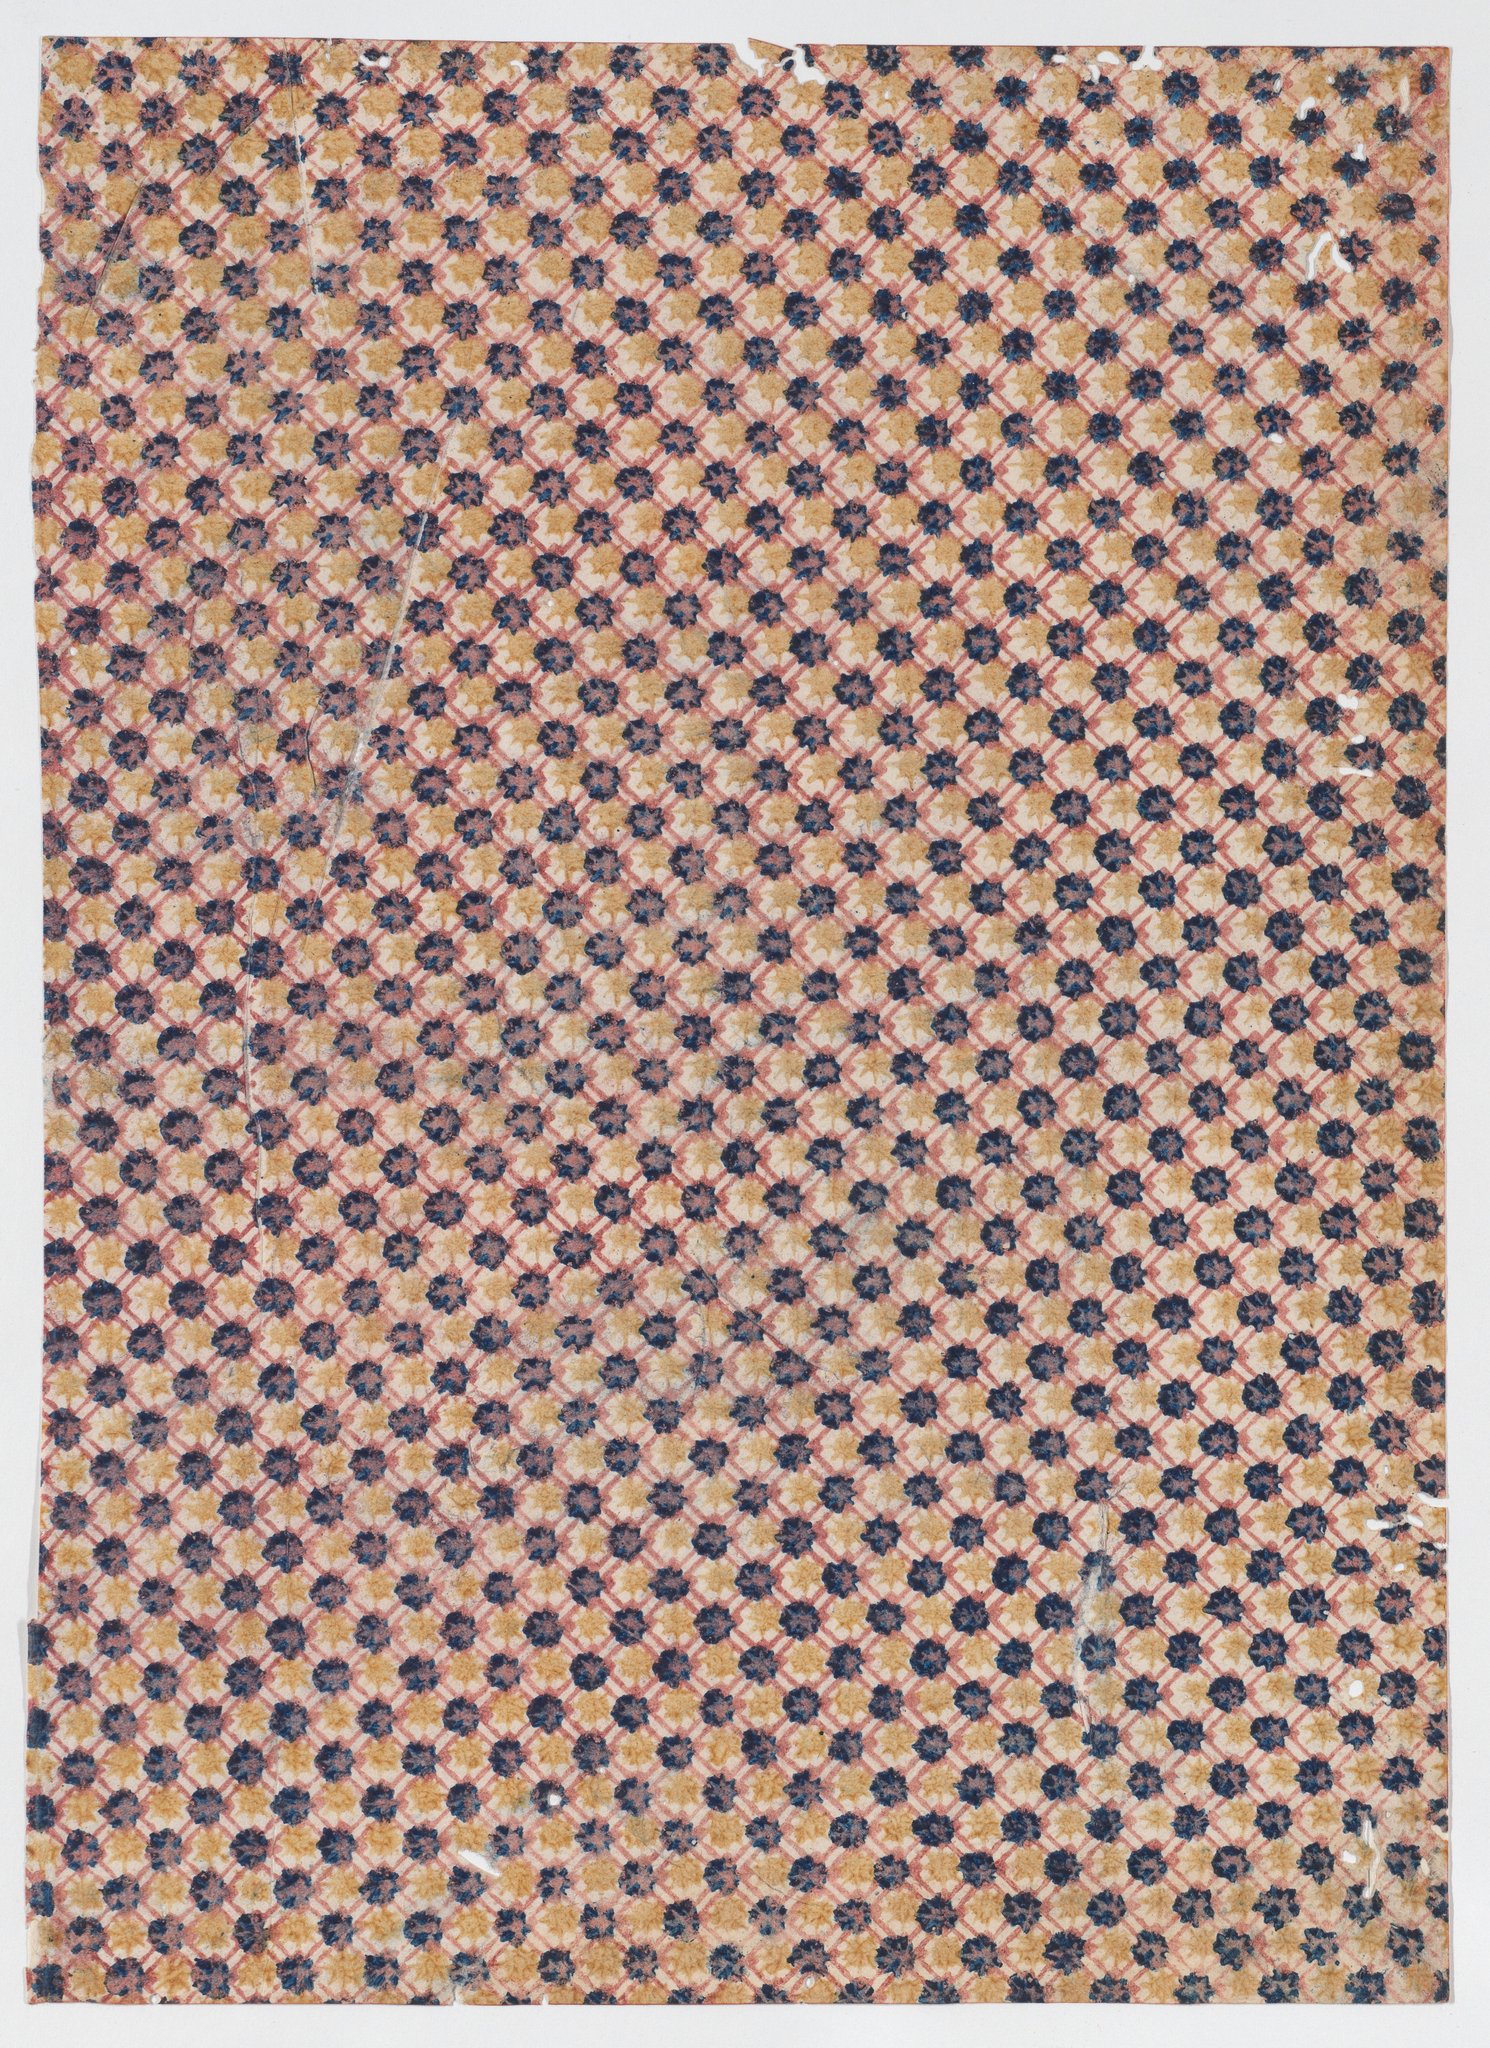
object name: print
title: Sheet with overall crisscrossing pattern with large dots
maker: Anonymous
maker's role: artist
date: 1801-1900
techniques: relief print